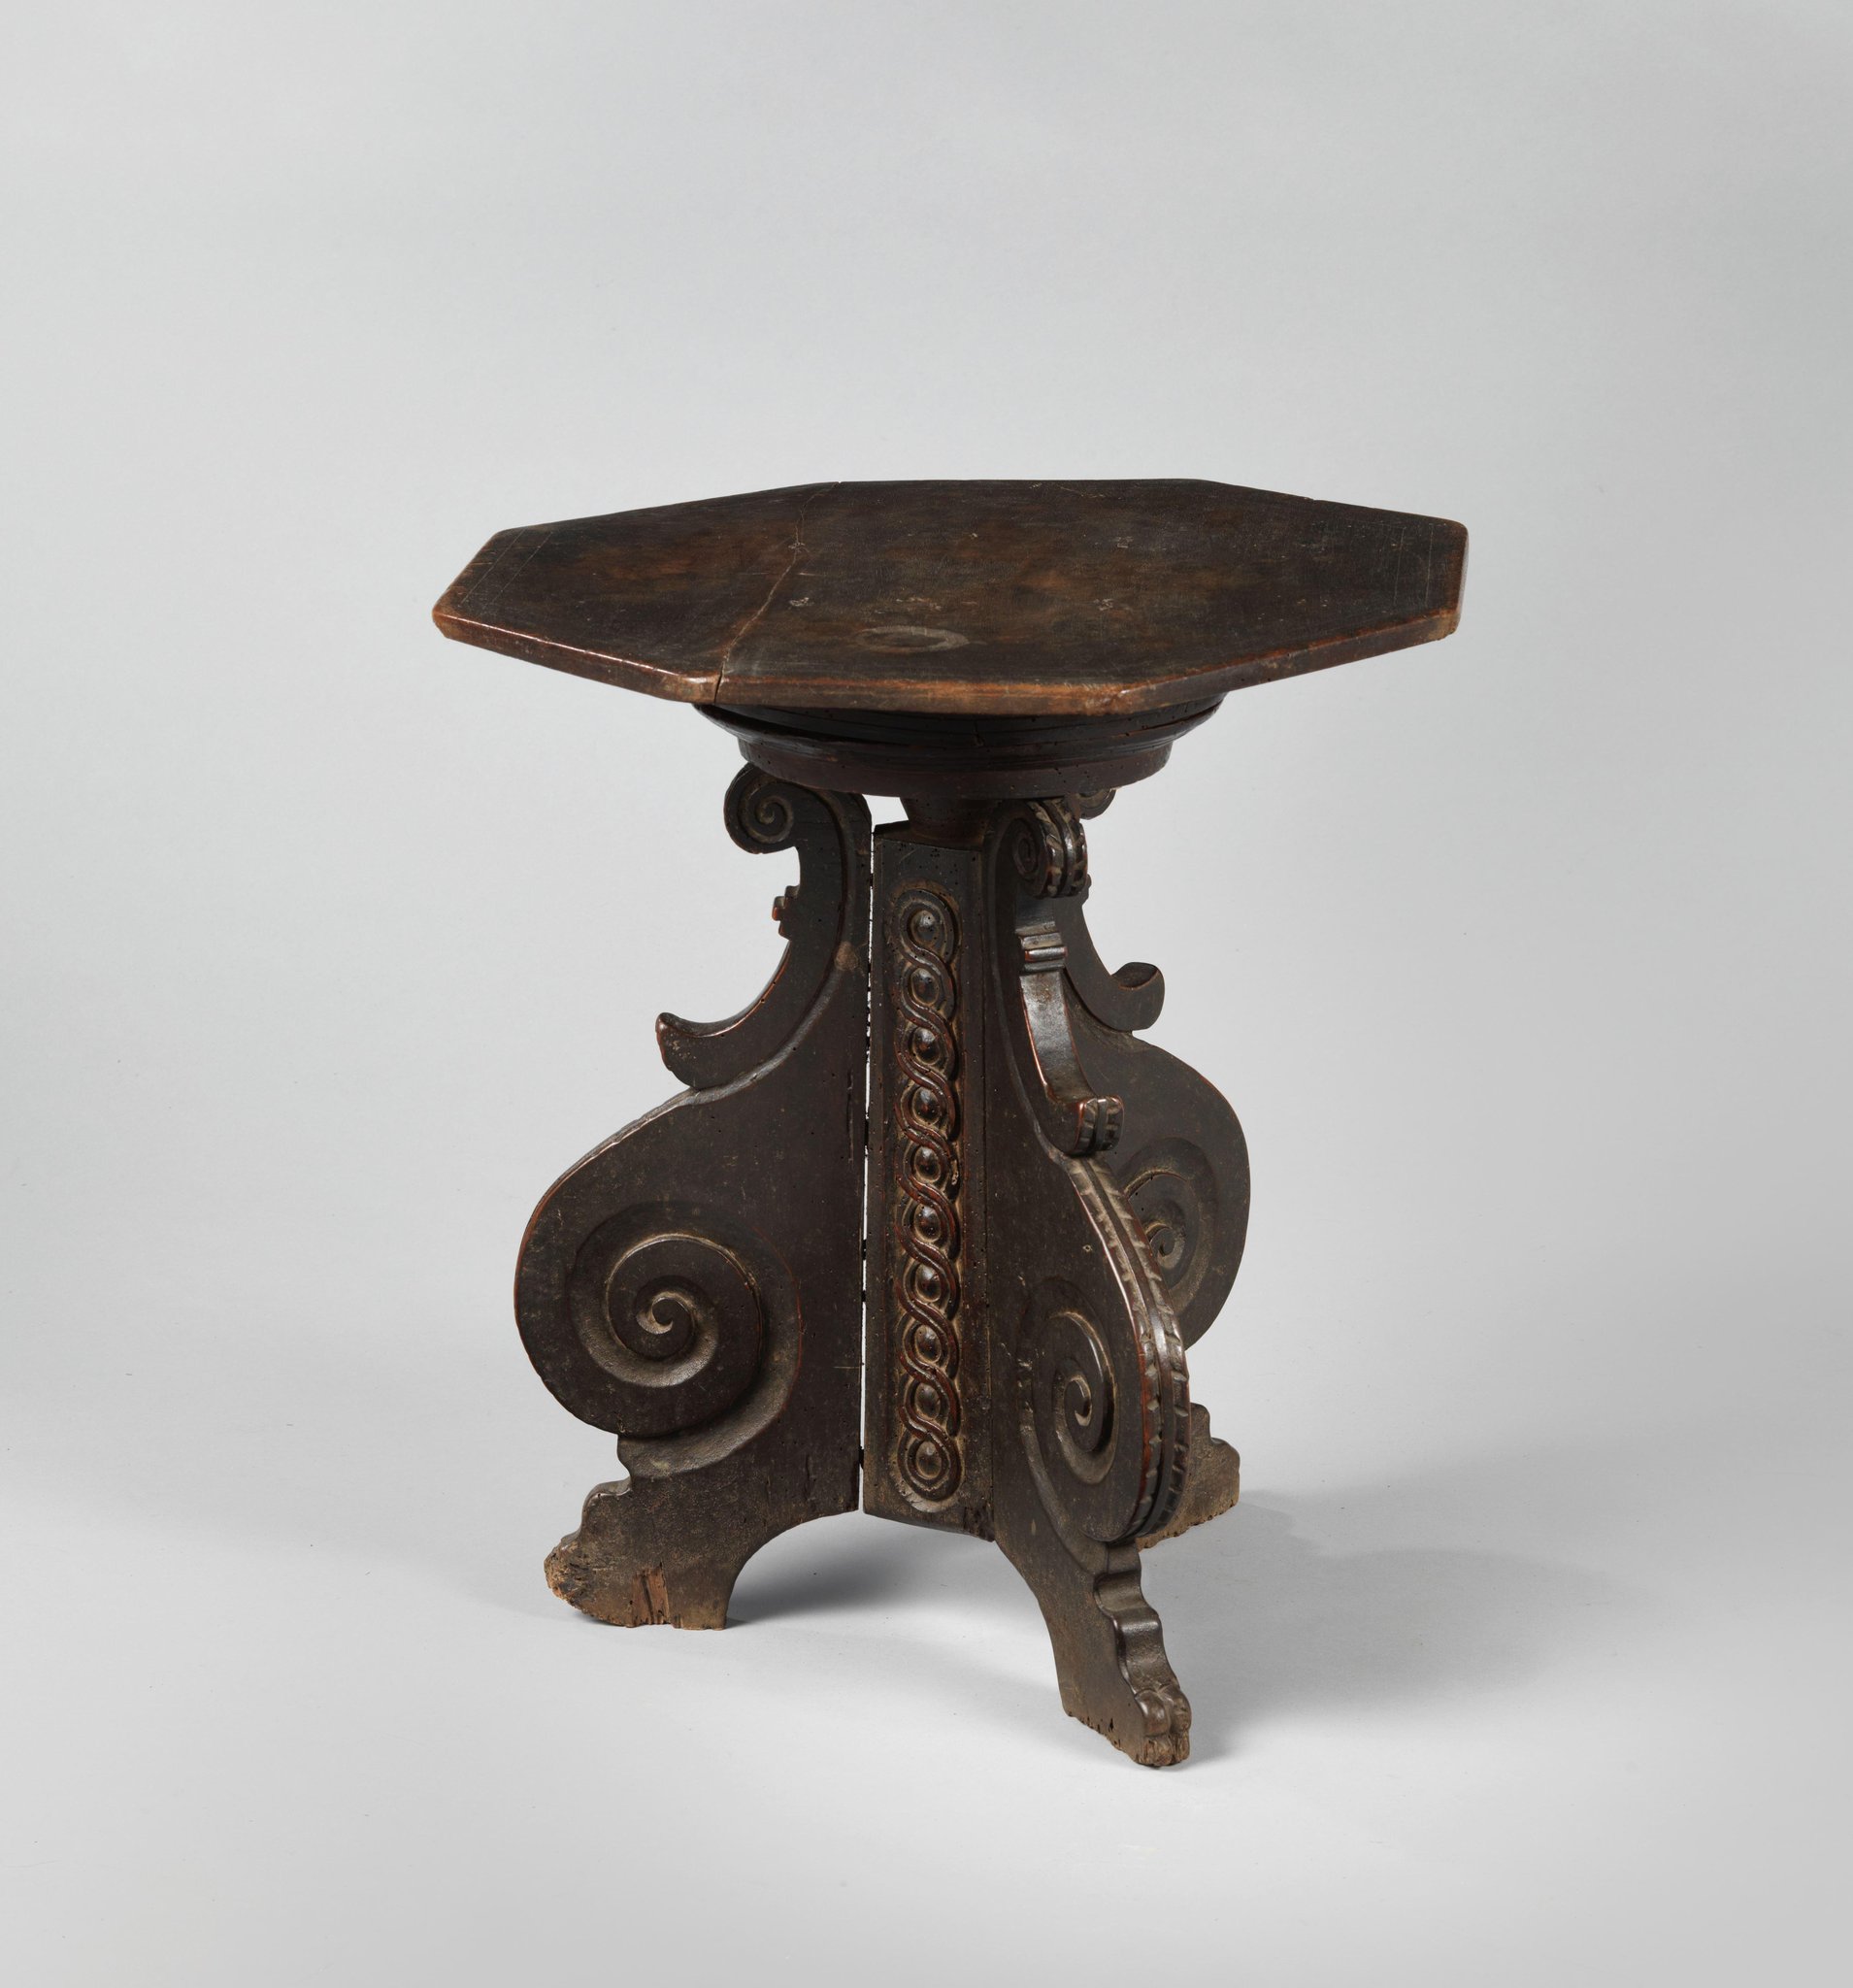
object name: table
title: Tafel van notenhout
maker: Anonymous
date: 1500-1600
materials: wood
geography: tuscany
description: Tafel van notenhout met achthoekig blad, dat met geprofileerde ronde schijven op de poot rust. Deze bestaat uit een driezijdige, met gestoken vlechtband versierde middenstijl, waaraan straalsgewijze drie platte wangen, die met voluutkrullen versierd zijn en in klauwen eindigen. Het blad is met de bovenste schijf door middel van een daarin bevestigde pen in de middenstijl gestoken en daardoor afneembaar en draaibaar. De ondereinden der poten ontbreken.